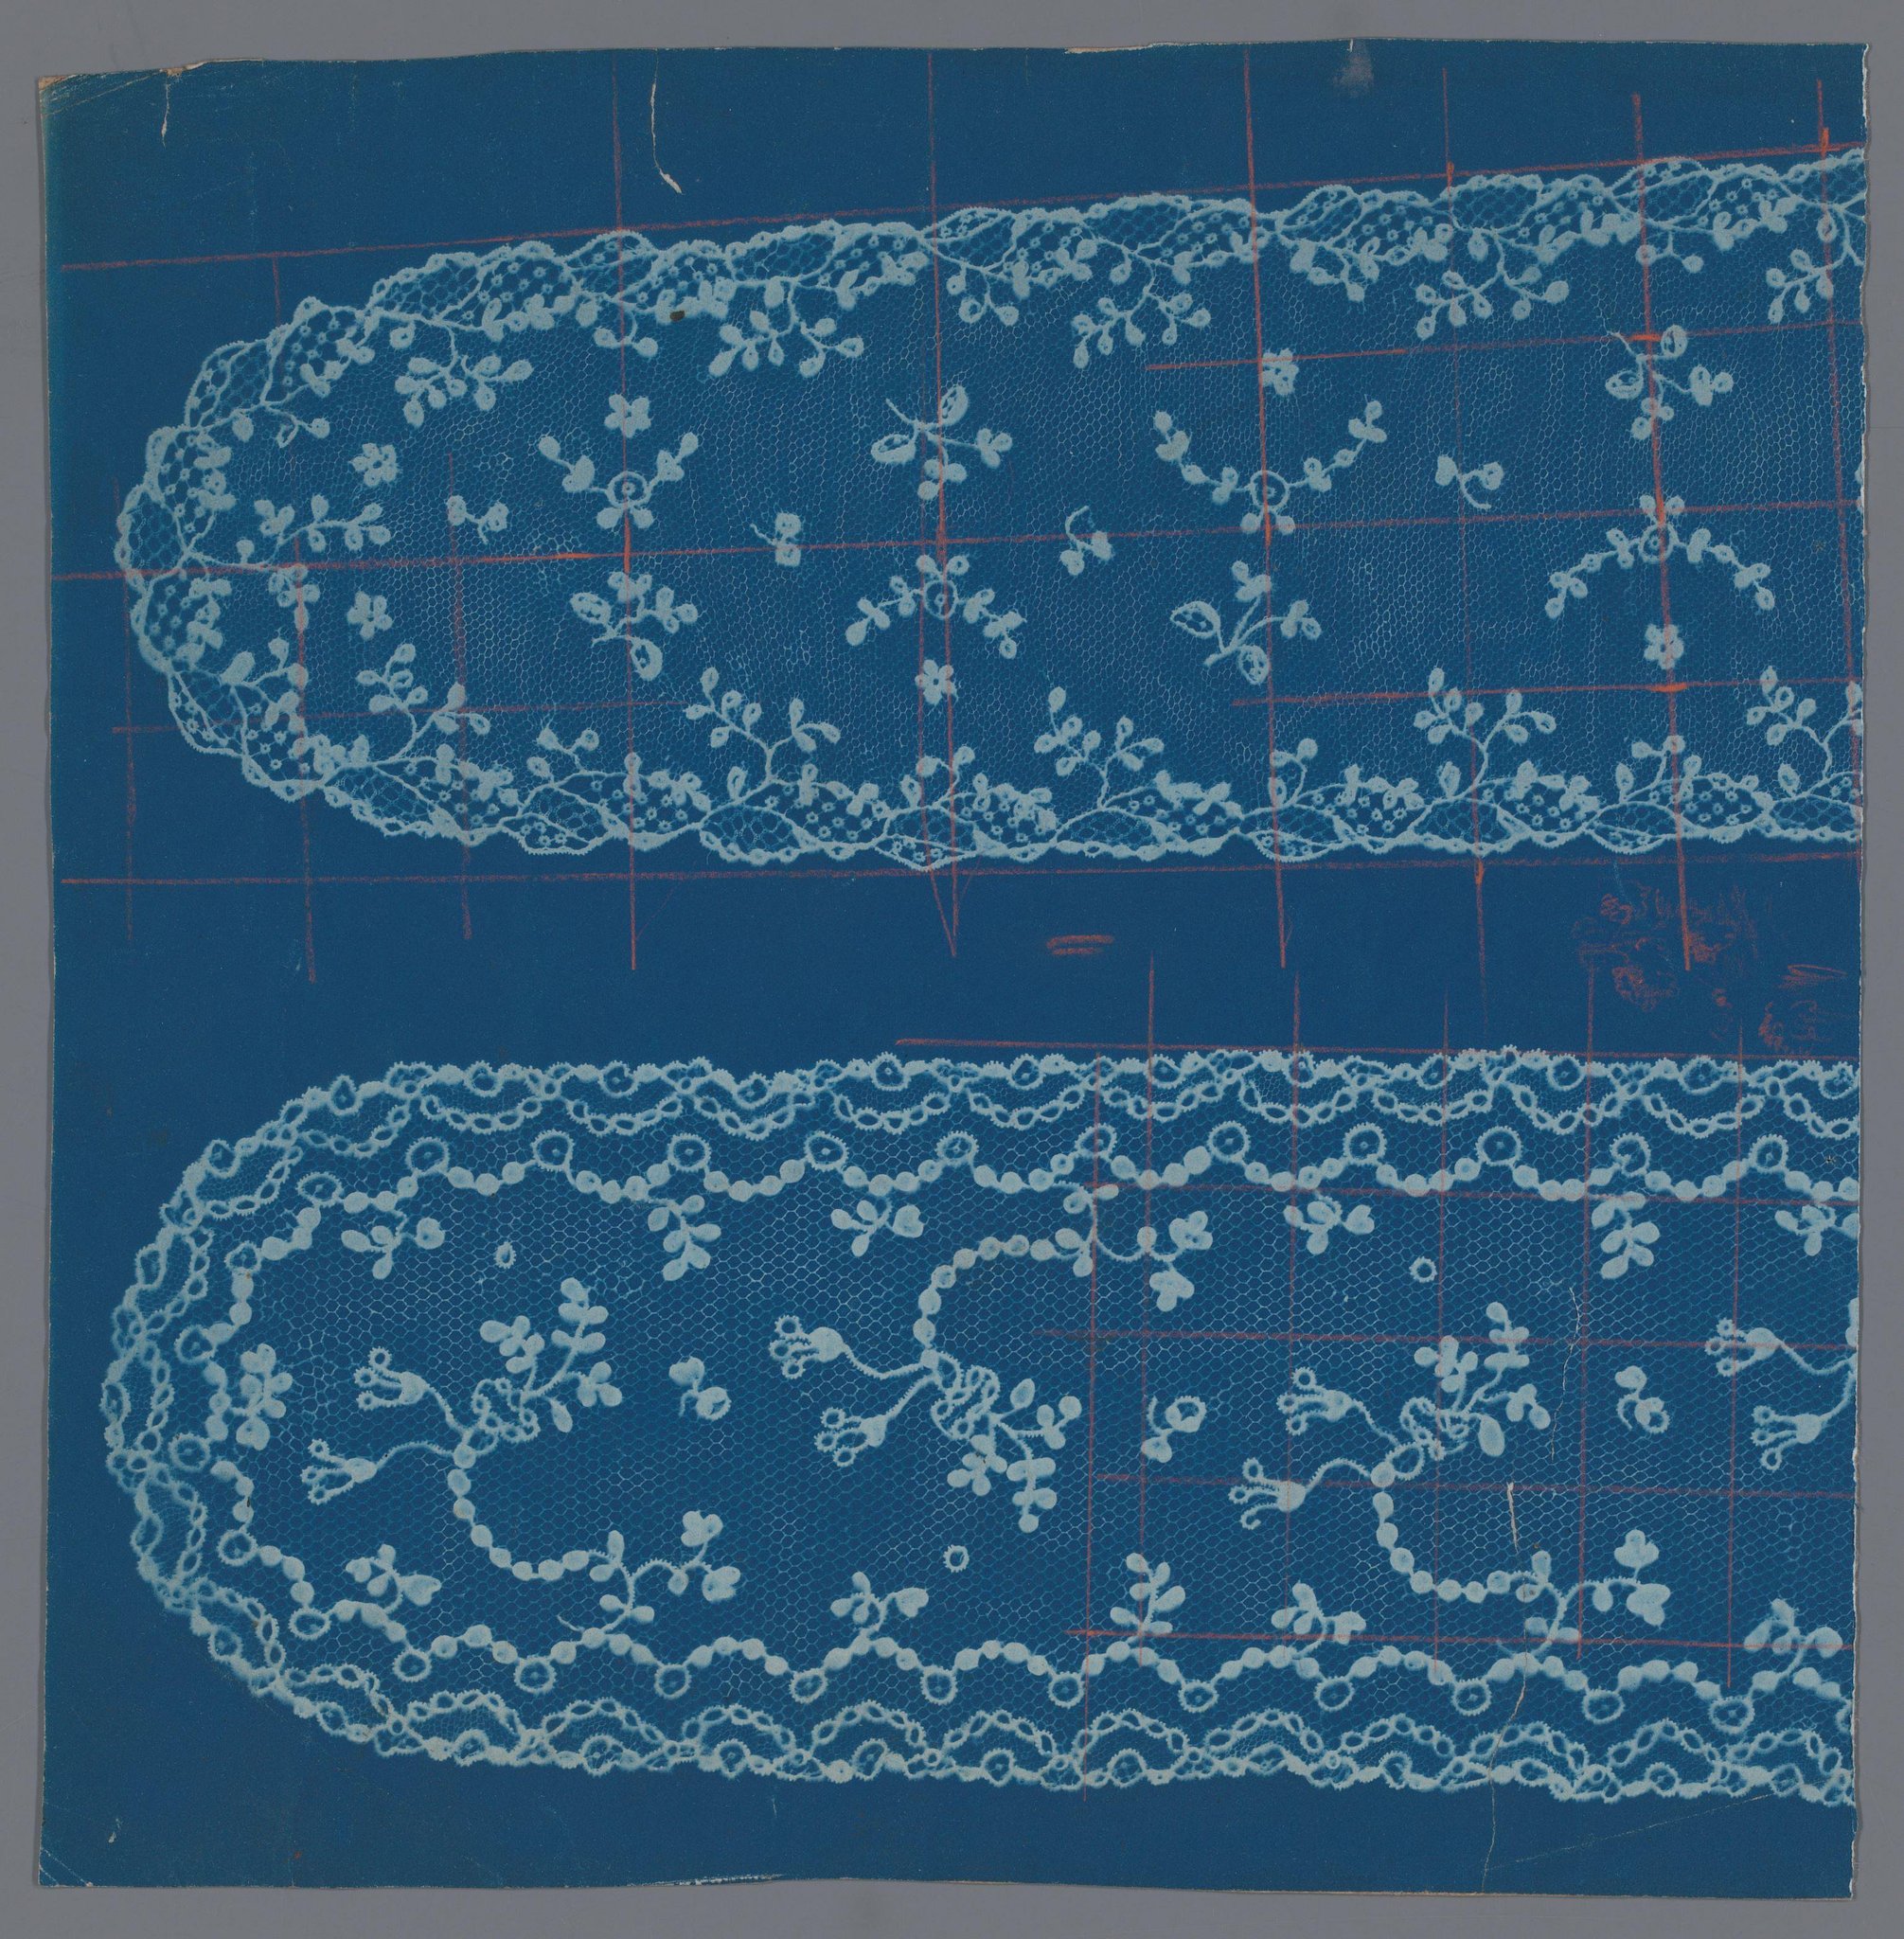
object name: photogram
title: Voorbeeld van kant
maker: Anonymous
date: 1890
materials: paper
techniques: cyanotype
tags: lace